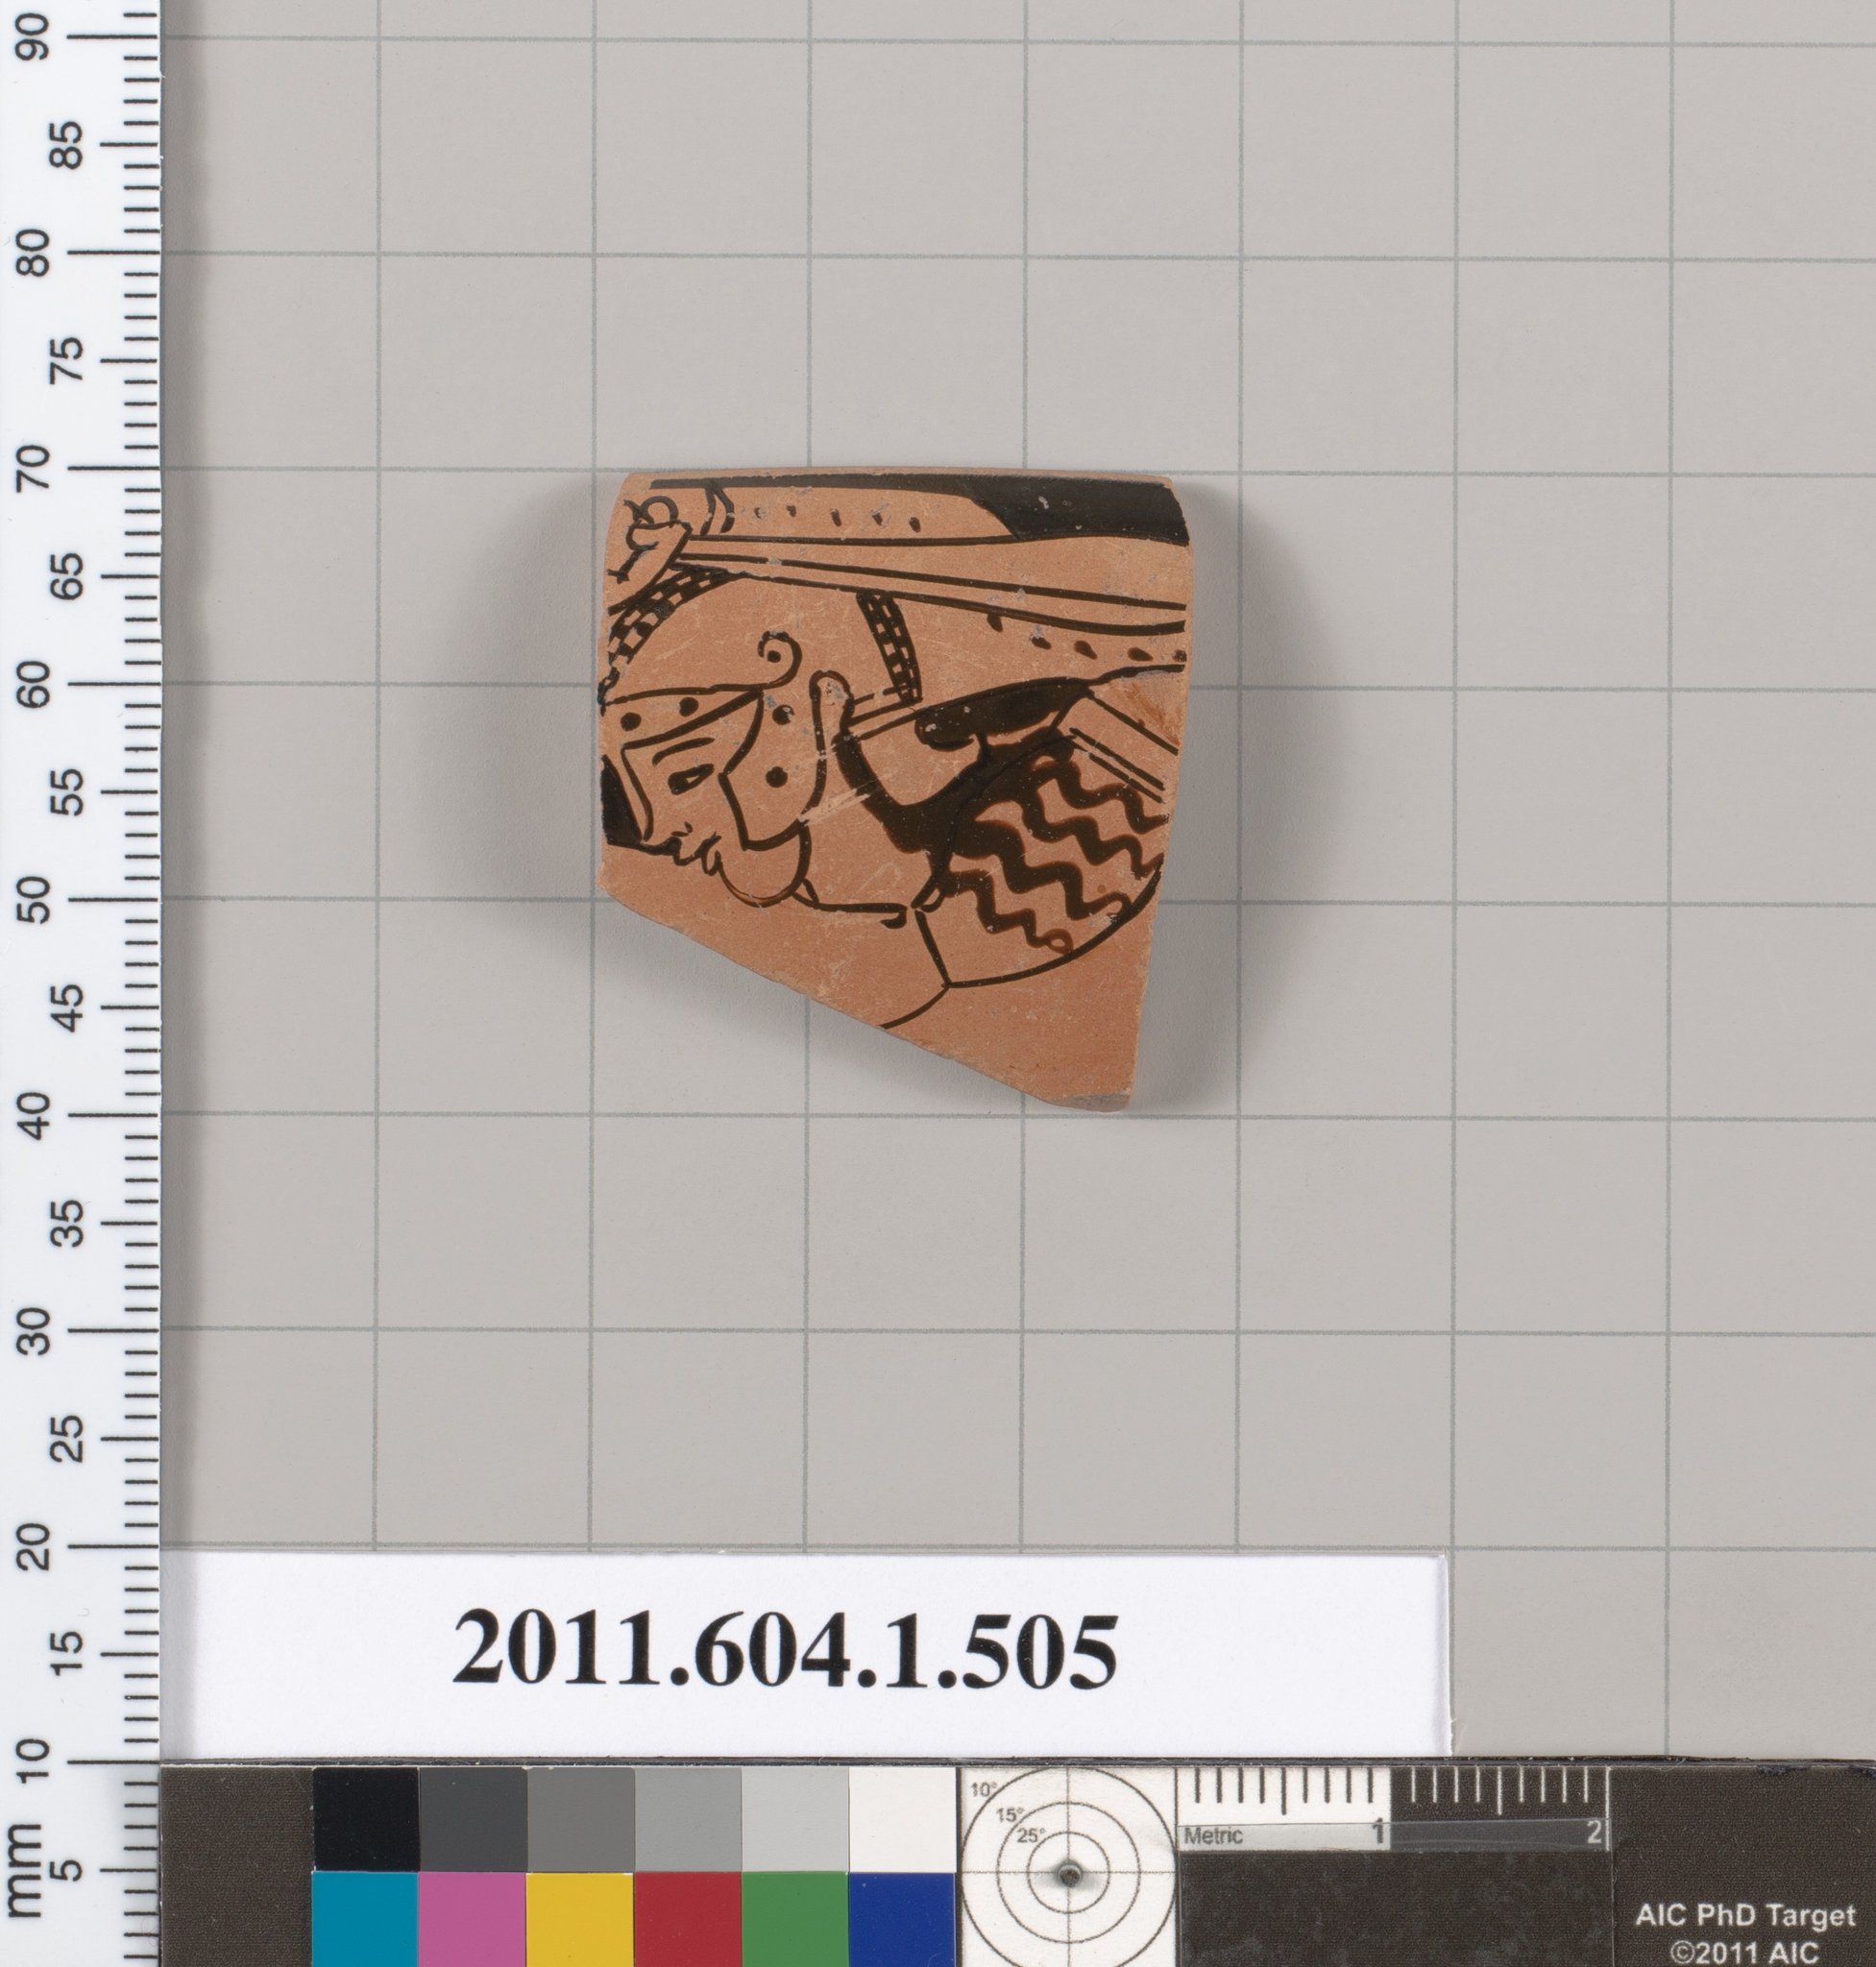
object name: kylix fragment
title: Terracotta rim fragment of a kylix (drinking cup)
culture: greek, attic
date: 500-468 BCE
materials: terracotta